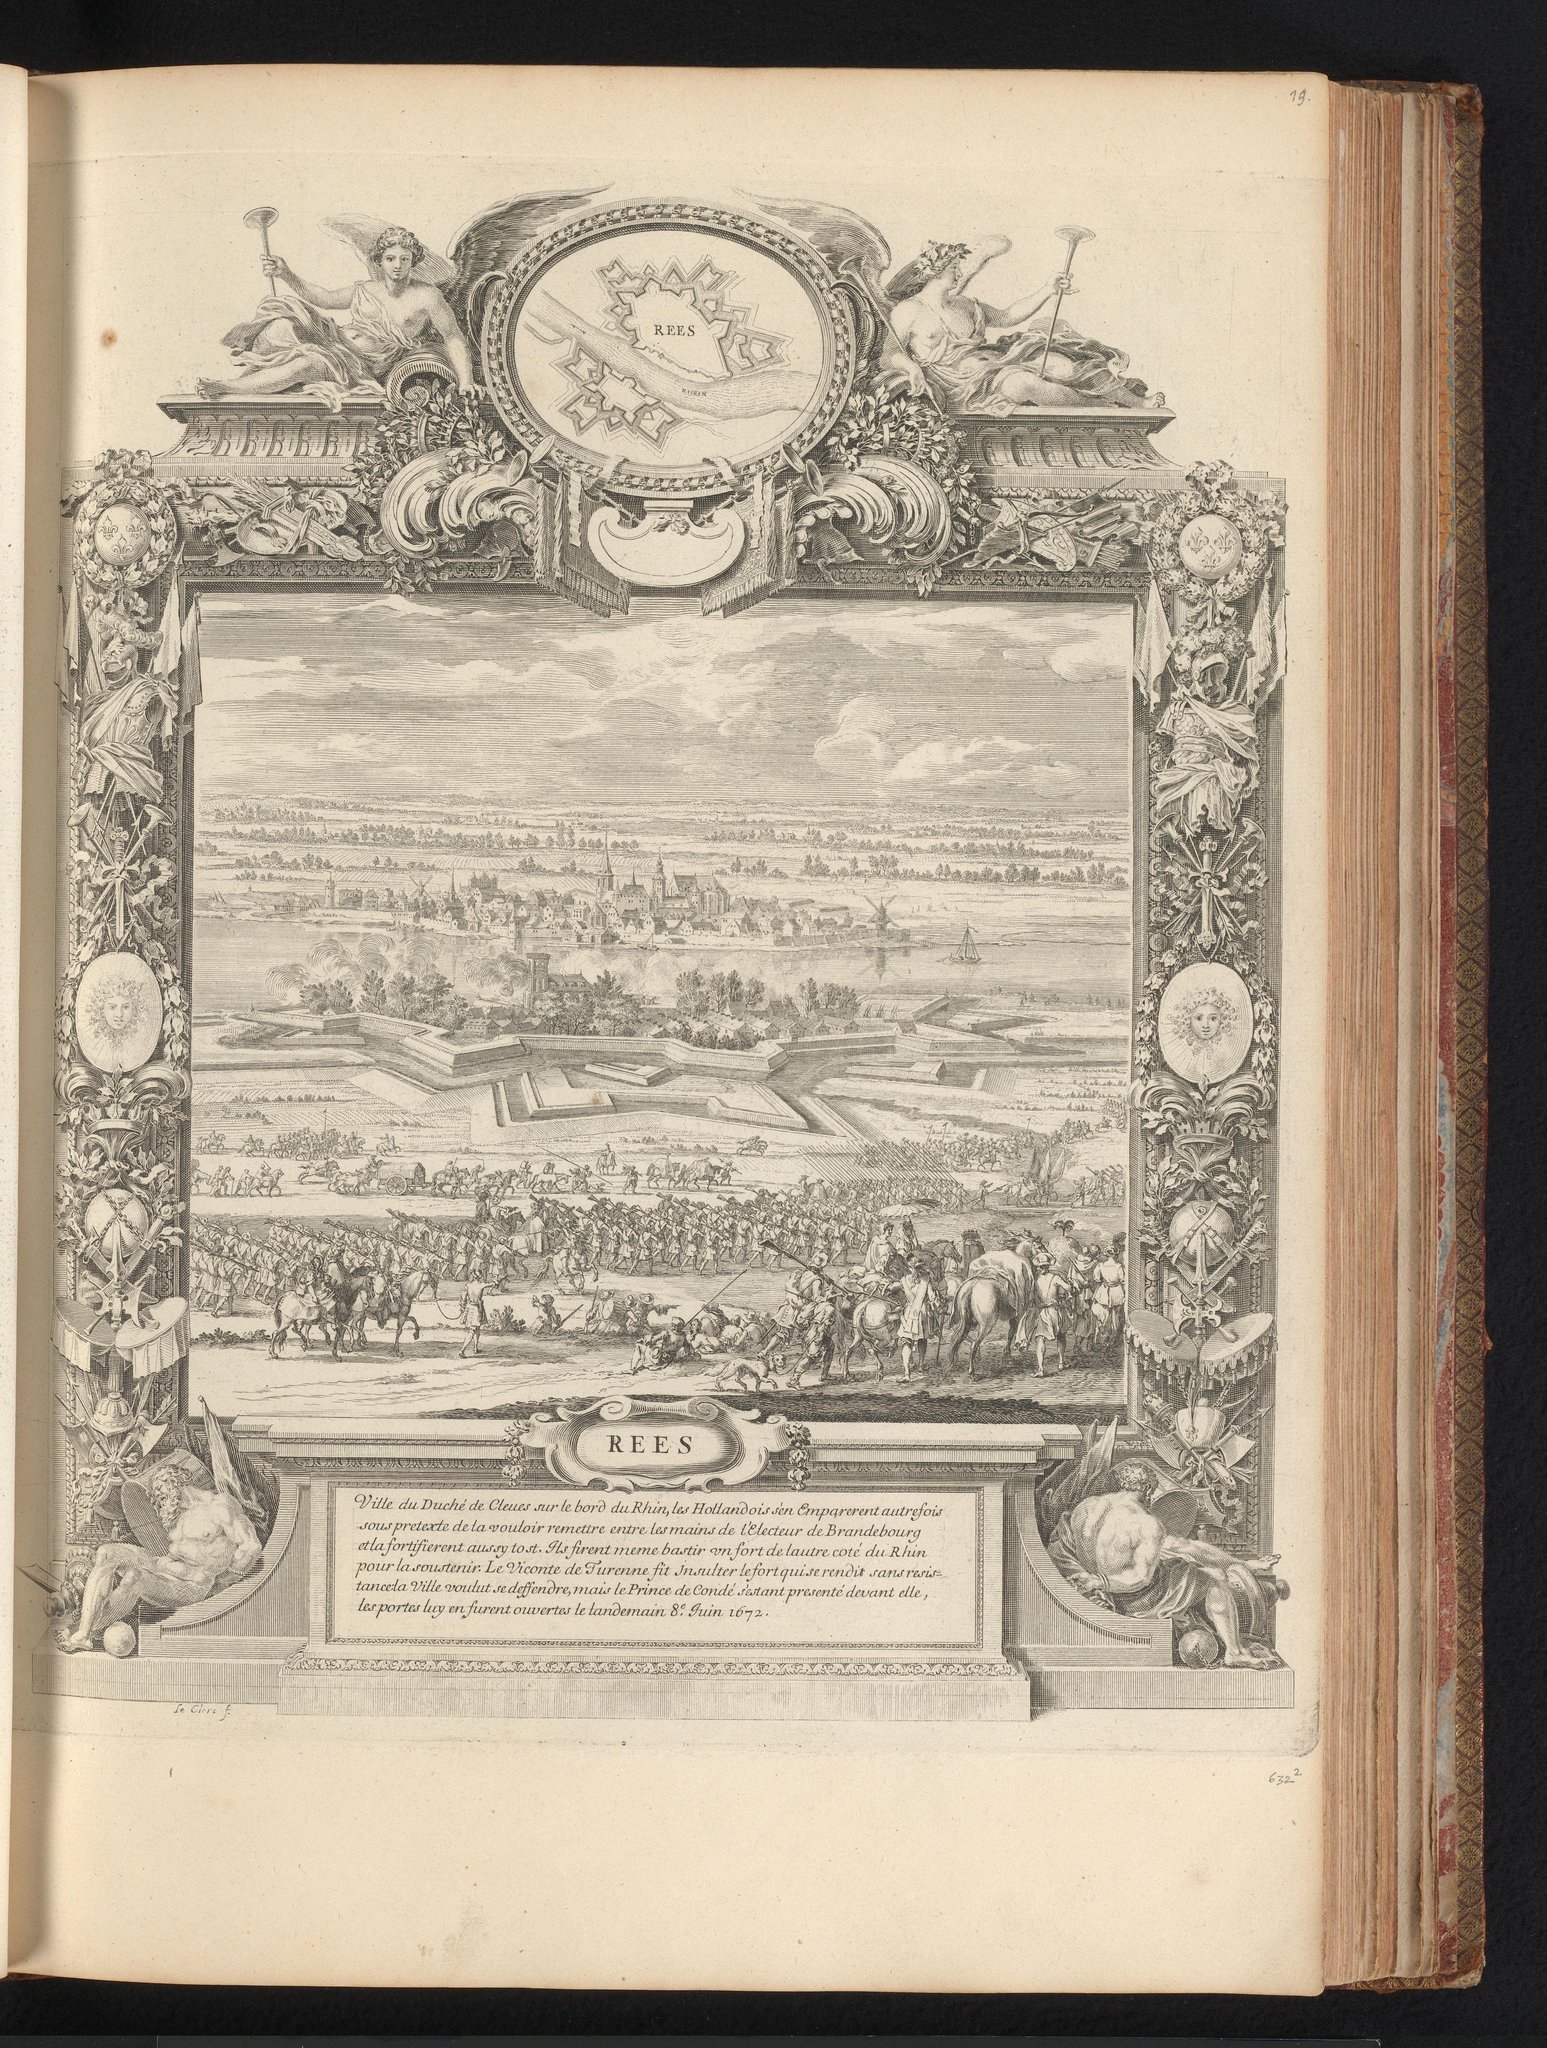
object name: album leaf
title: Grandes conquêtes du Roi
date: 1690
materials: paper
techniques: engraving, etching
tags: capture of city (after the siege)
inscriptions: watermark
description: Maakt deel uit van een serie bestaande uit 28 prenten met oorlogstaferelen in ornamentele cartouches. De prenten zijn gedrukt van twee afzonderlijke platen bestaande uit de voorstelling en de cartouche.